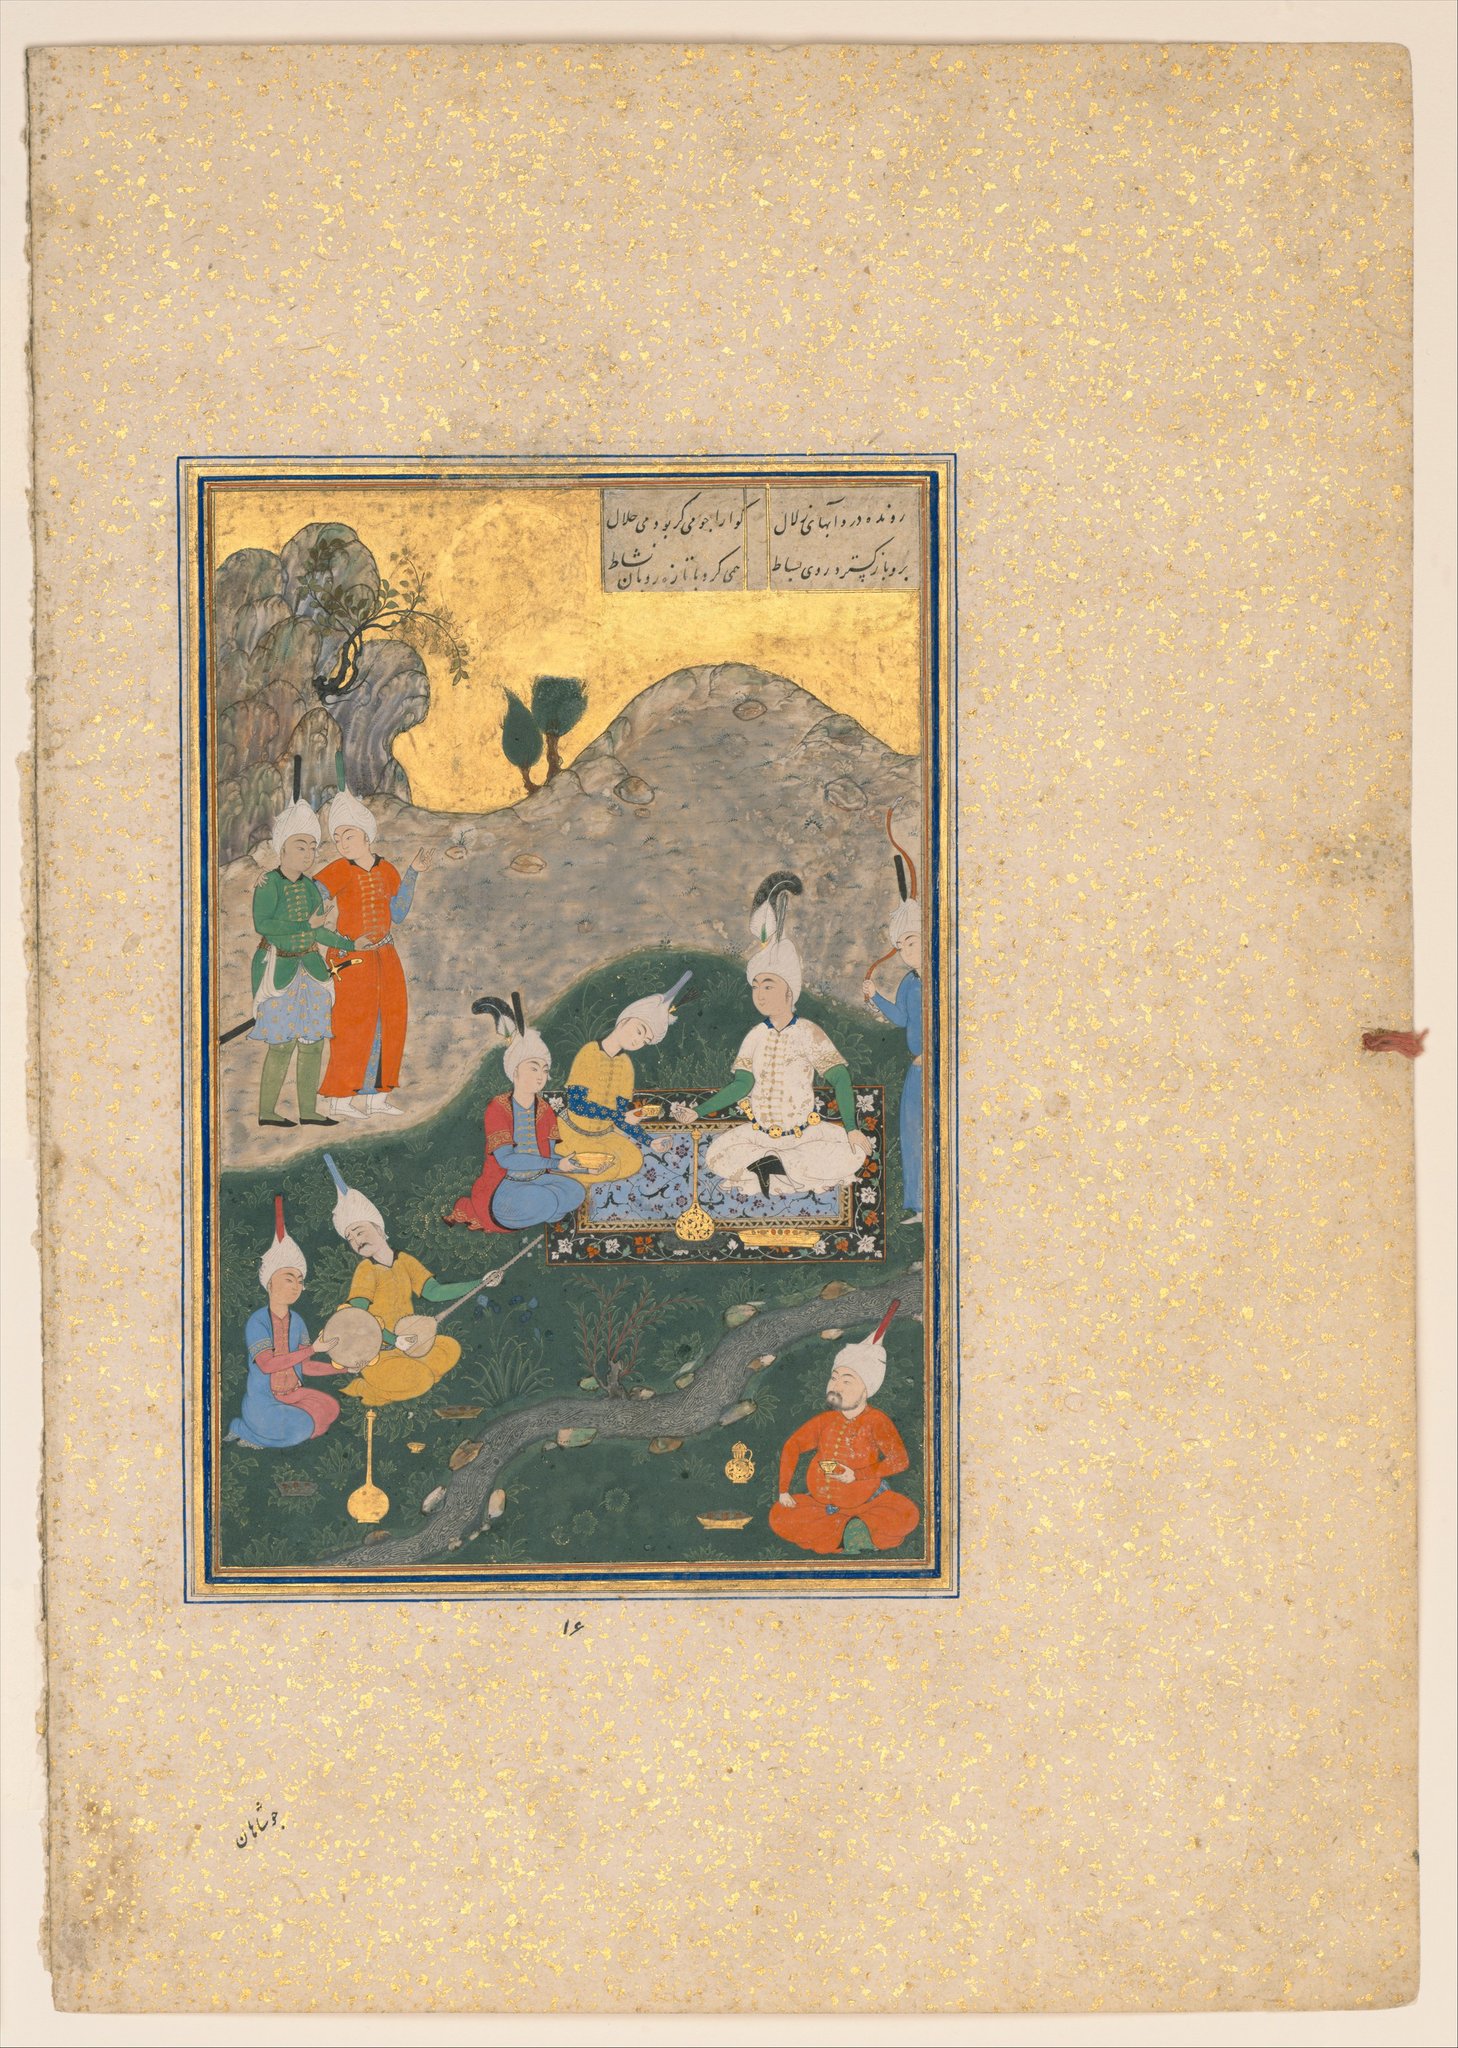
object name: folio from an illustrated manuscript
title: "Alexander at a Banquet", Folio 321b from a Khamsa (Quintet) of Nizami of Ganja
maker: nizami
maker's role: author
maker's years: 1141-1209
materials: gold, ink, paper, silver, watercolor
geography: afghanistan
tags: musical instruments,alexander the great,men